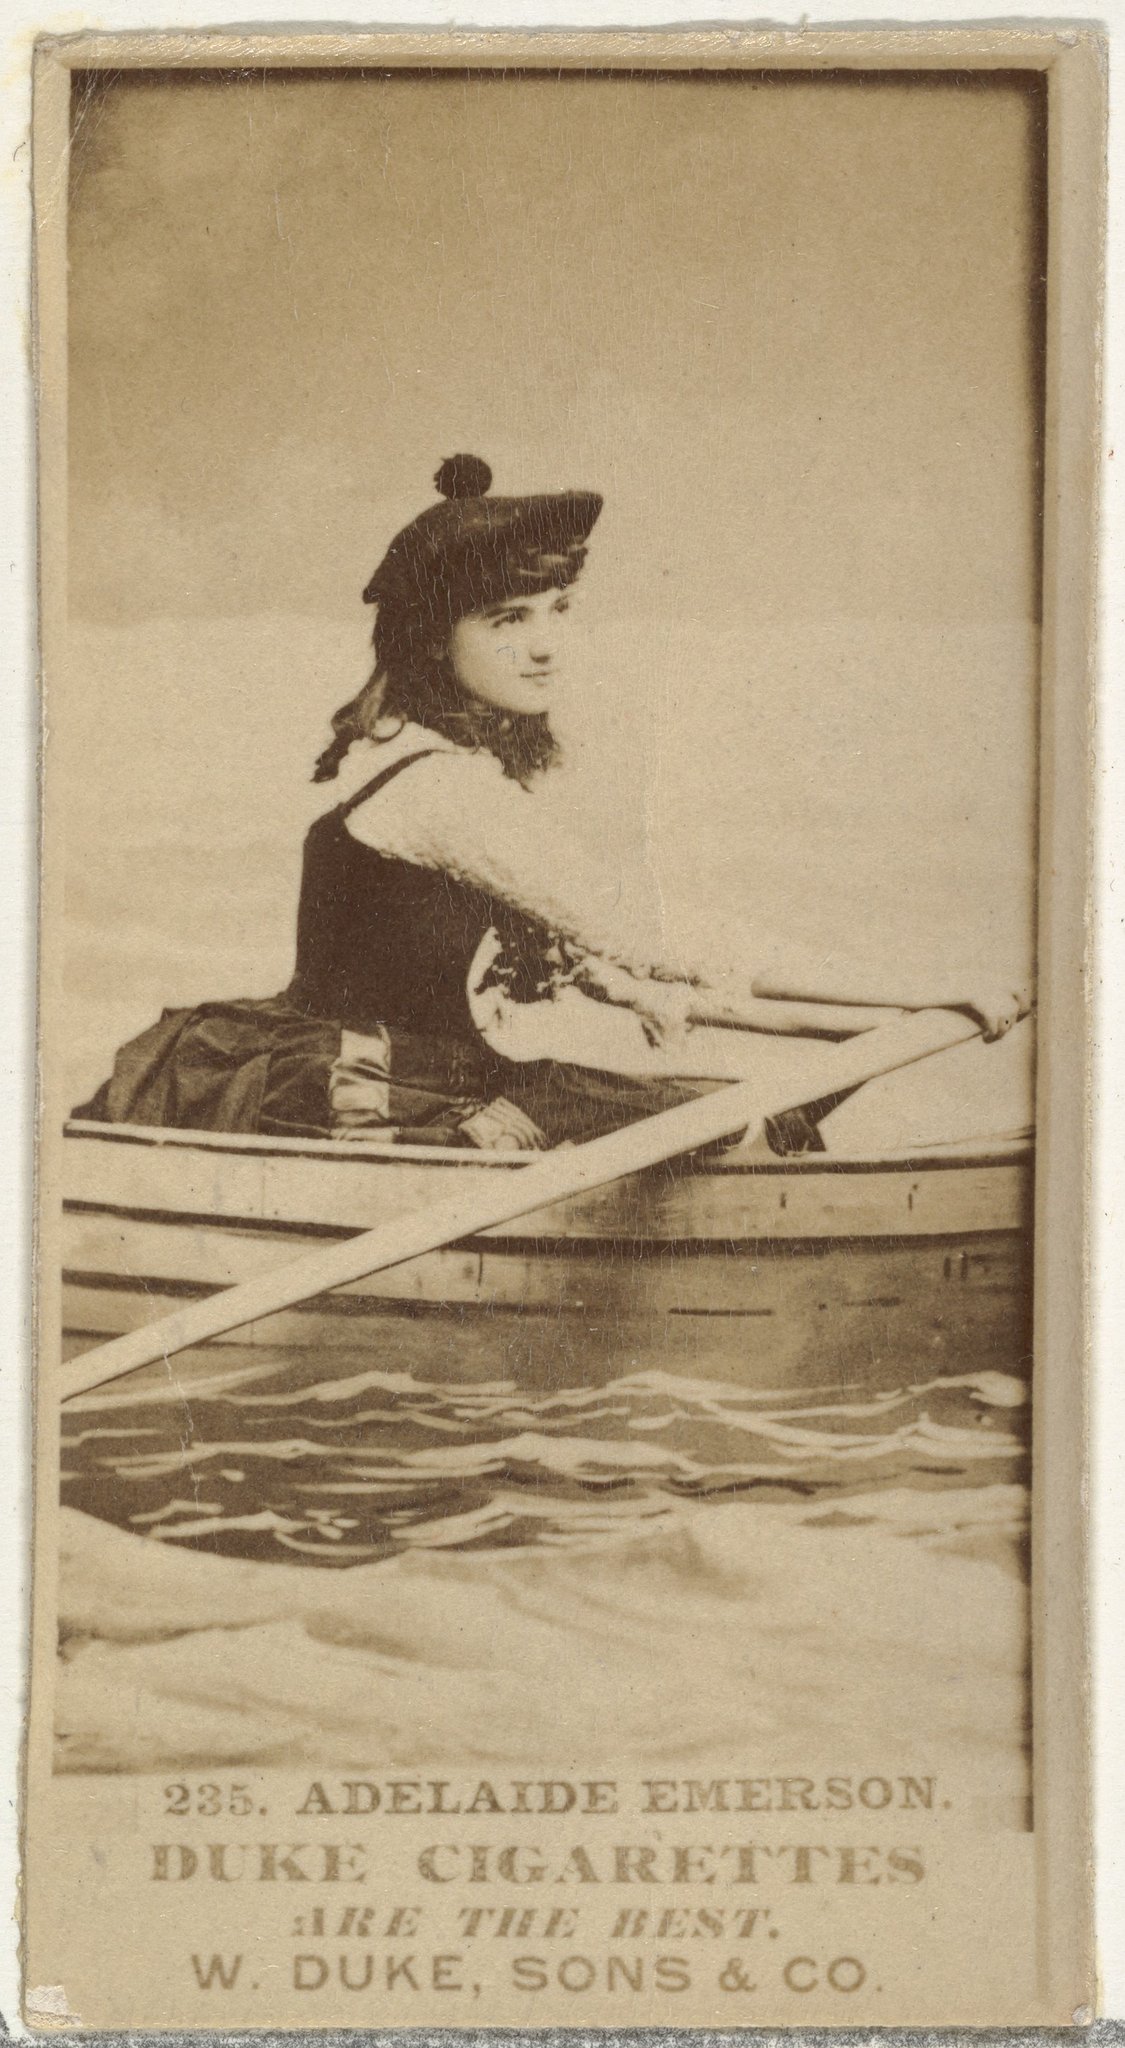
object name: photograph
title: Card Number 235, Adelaide Emerson, from the Actors and Actresses series (N145-7) issued by Duke Sons & Co. to promote Duke Cigarettes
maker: w. duke, sons & co.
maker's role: publisher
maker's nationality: american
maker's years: 1870-1920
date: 1880-1889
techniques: albumen silver print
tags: portraits,women,rowing,actresses,boats